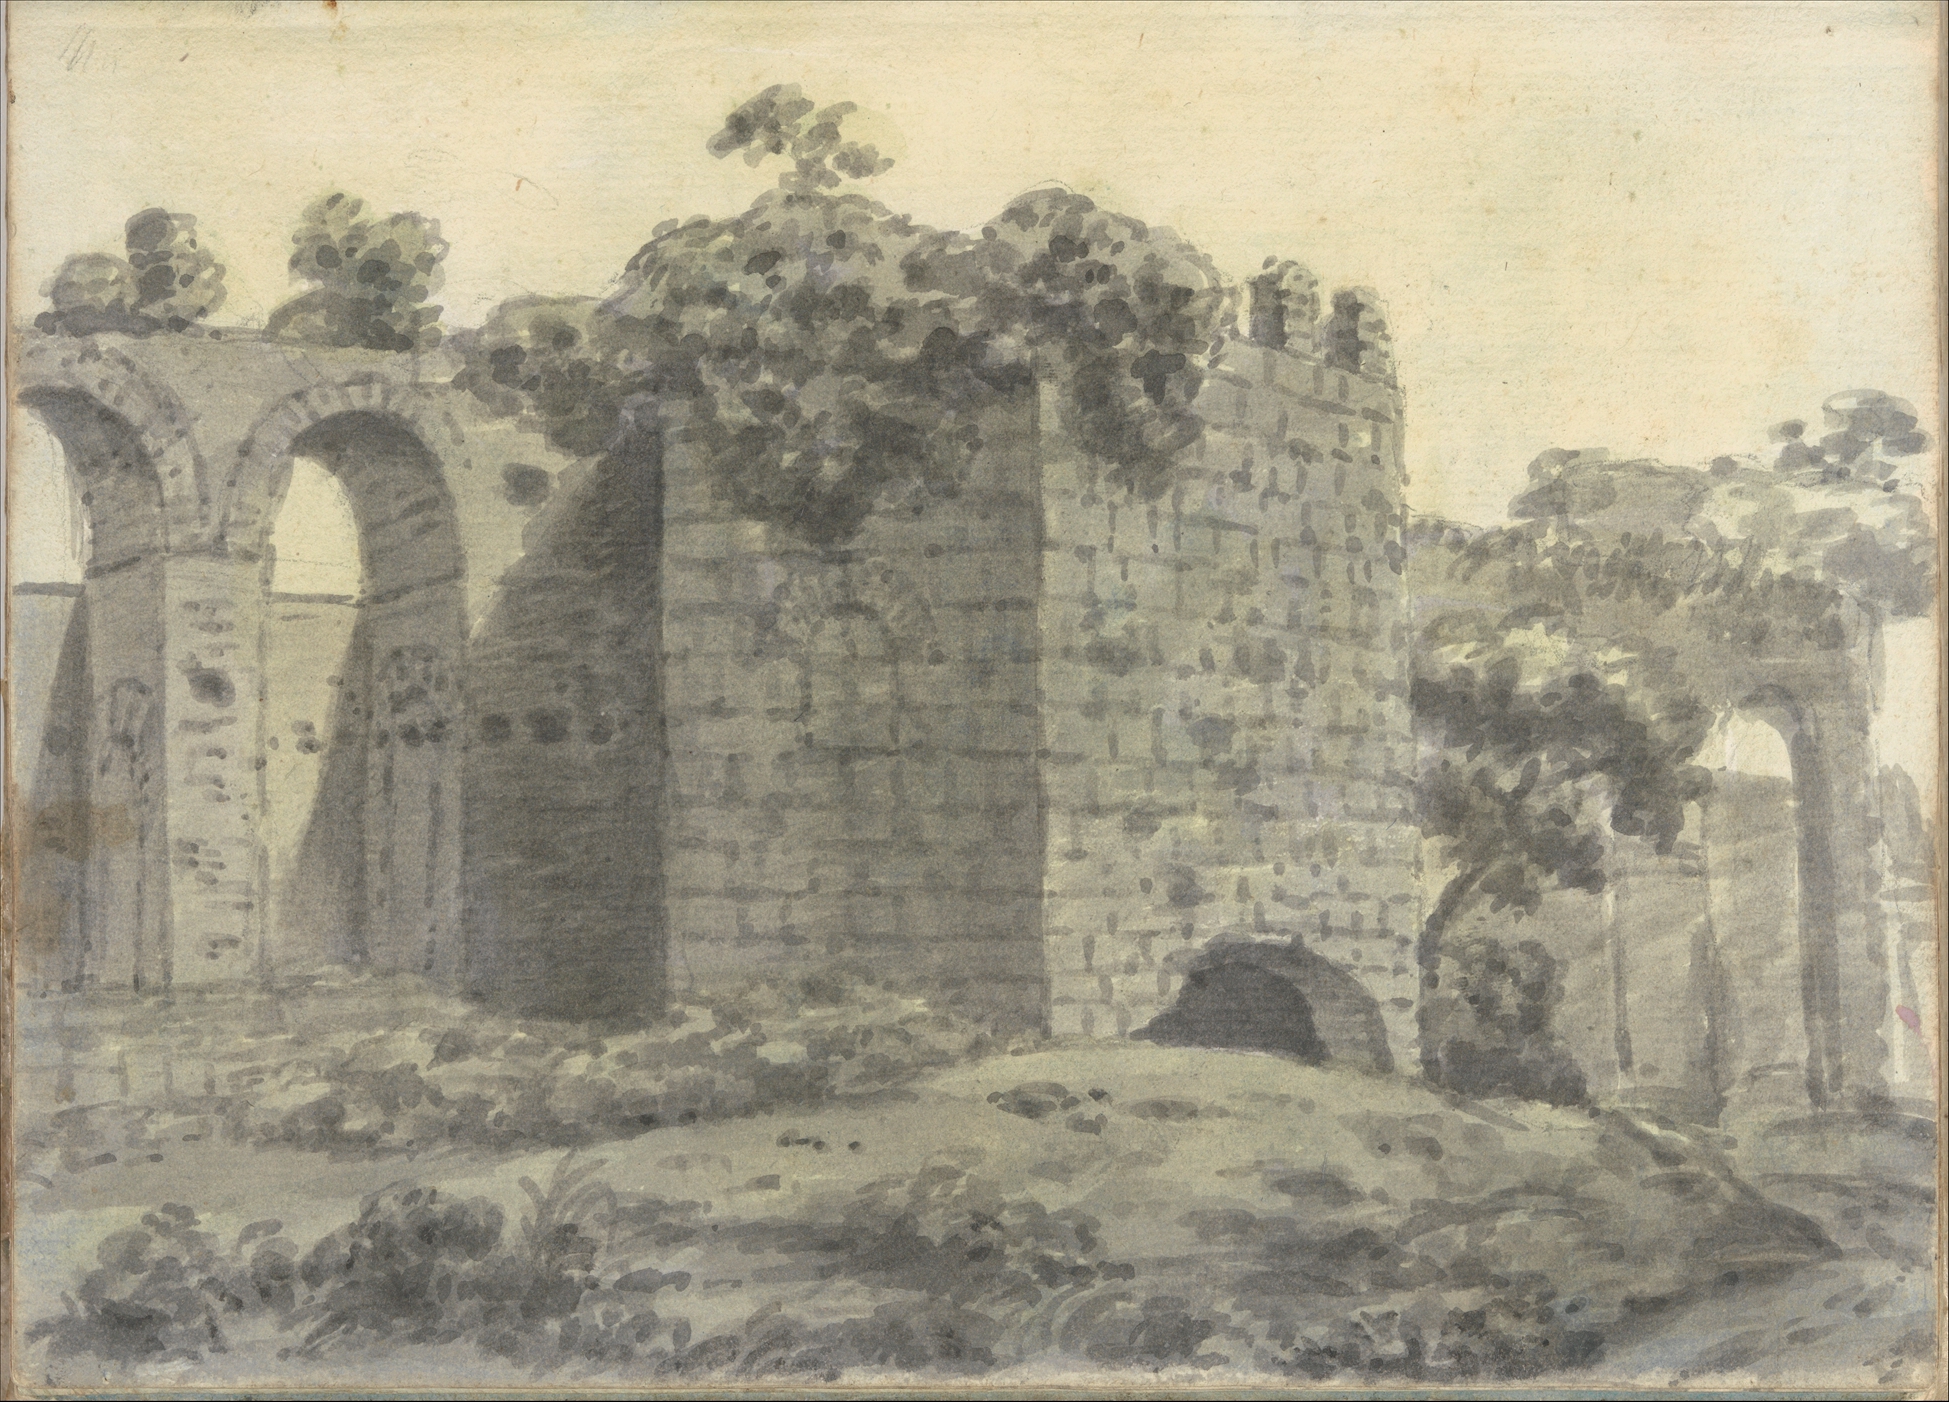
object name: drawing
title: Roman ruins Including an arched aqueduct and tower (Smaller Italian sketchbook, leaf 2 recto)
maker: joseph wright (wright of derby)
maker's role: artist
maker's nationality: british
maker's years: 1734-1797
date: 1774-1775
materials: ink, watercolor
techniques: brush, wash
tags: ruins,aqueducts